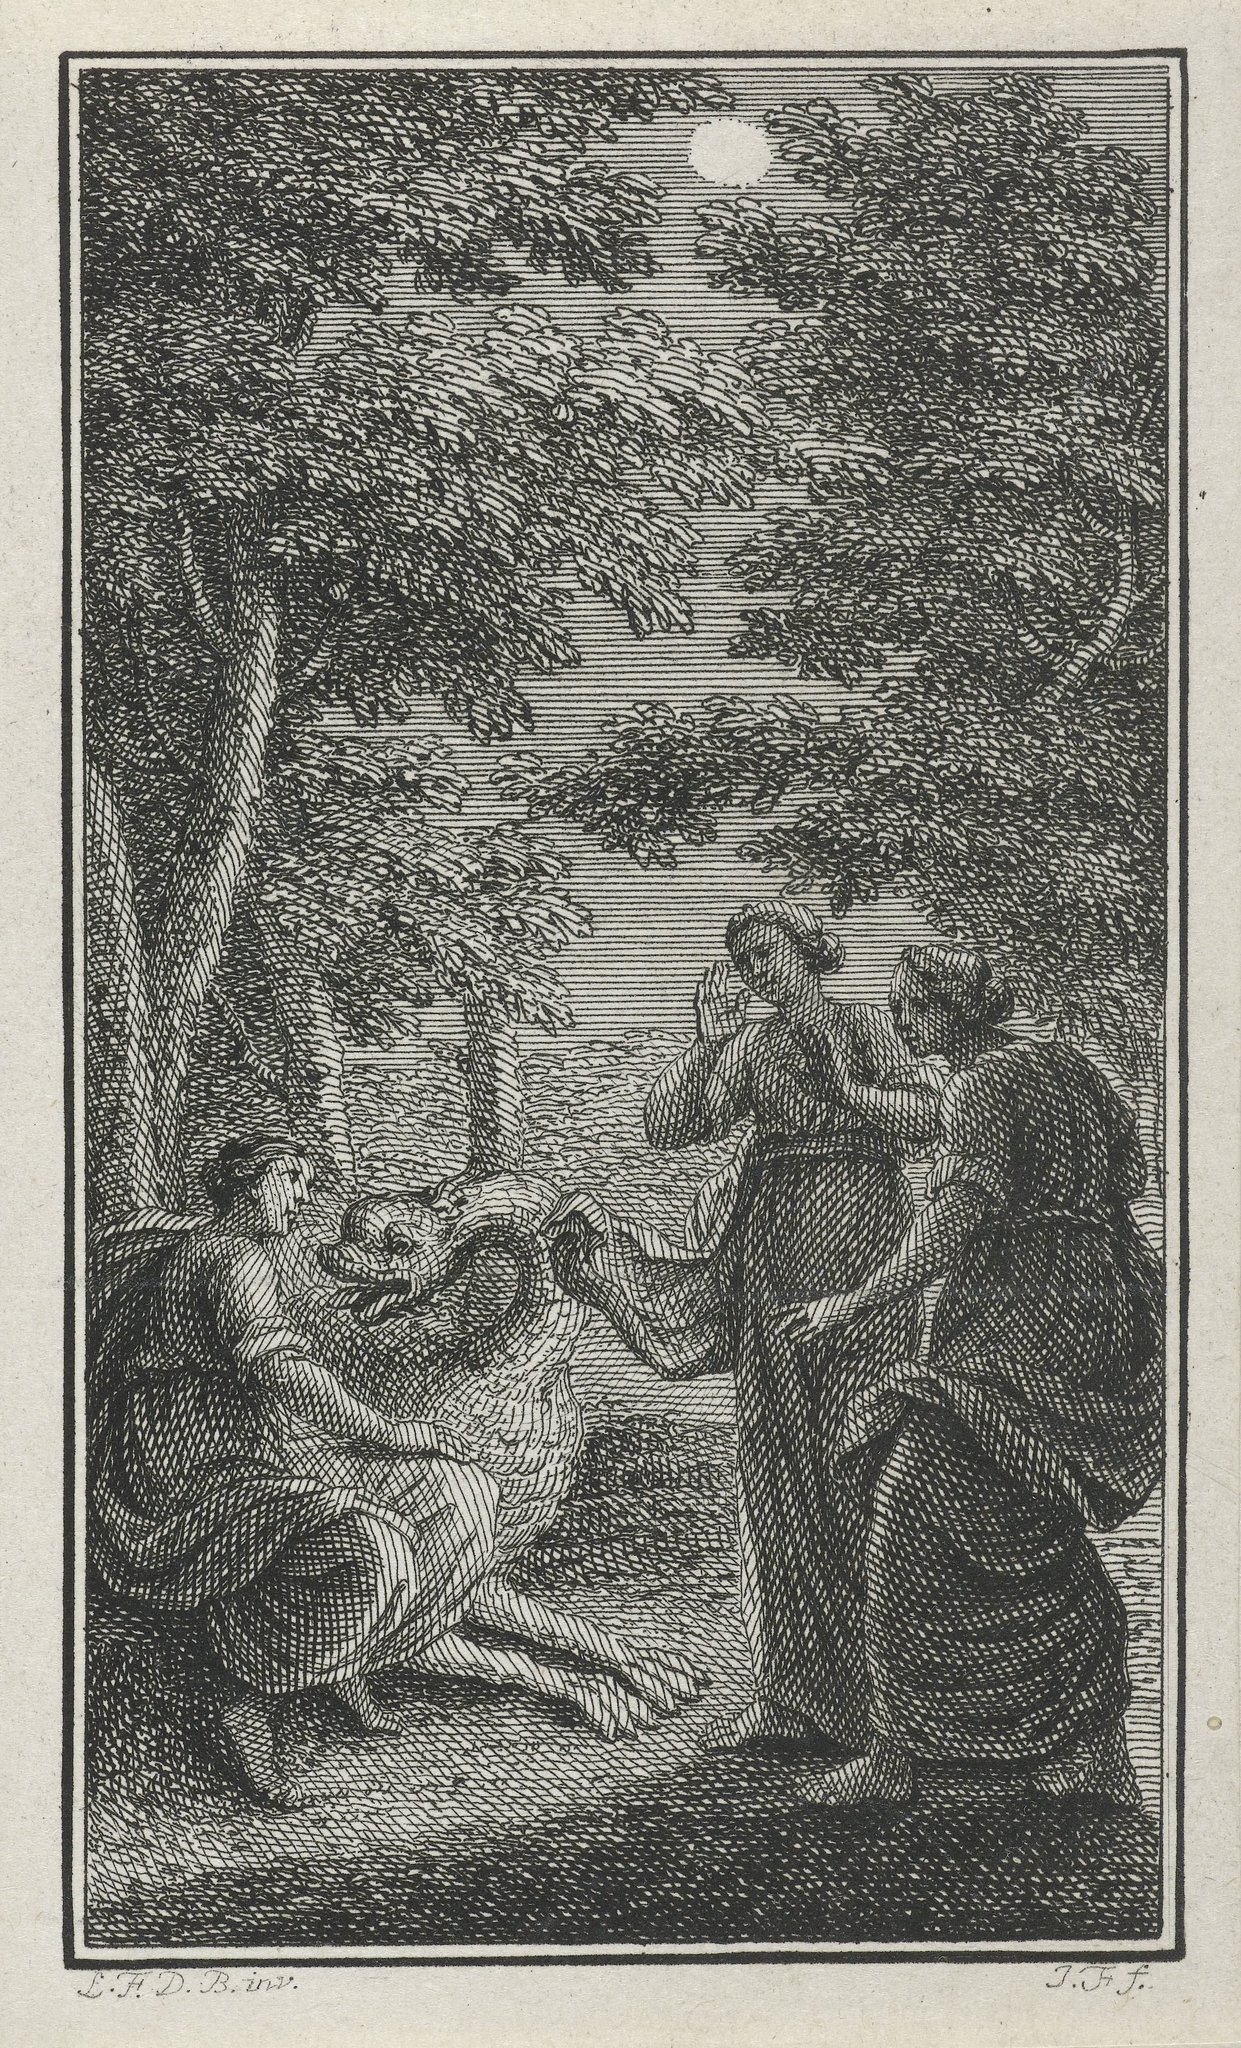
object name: print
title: Drie vrouwen en een draak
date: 1703-1767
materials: paper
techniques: etching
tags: dragon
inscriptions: collector's mark: Lugt 240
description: In een bos kijken twee vrouwen verschrikt naar een derde vrouw die naast een draak zit.